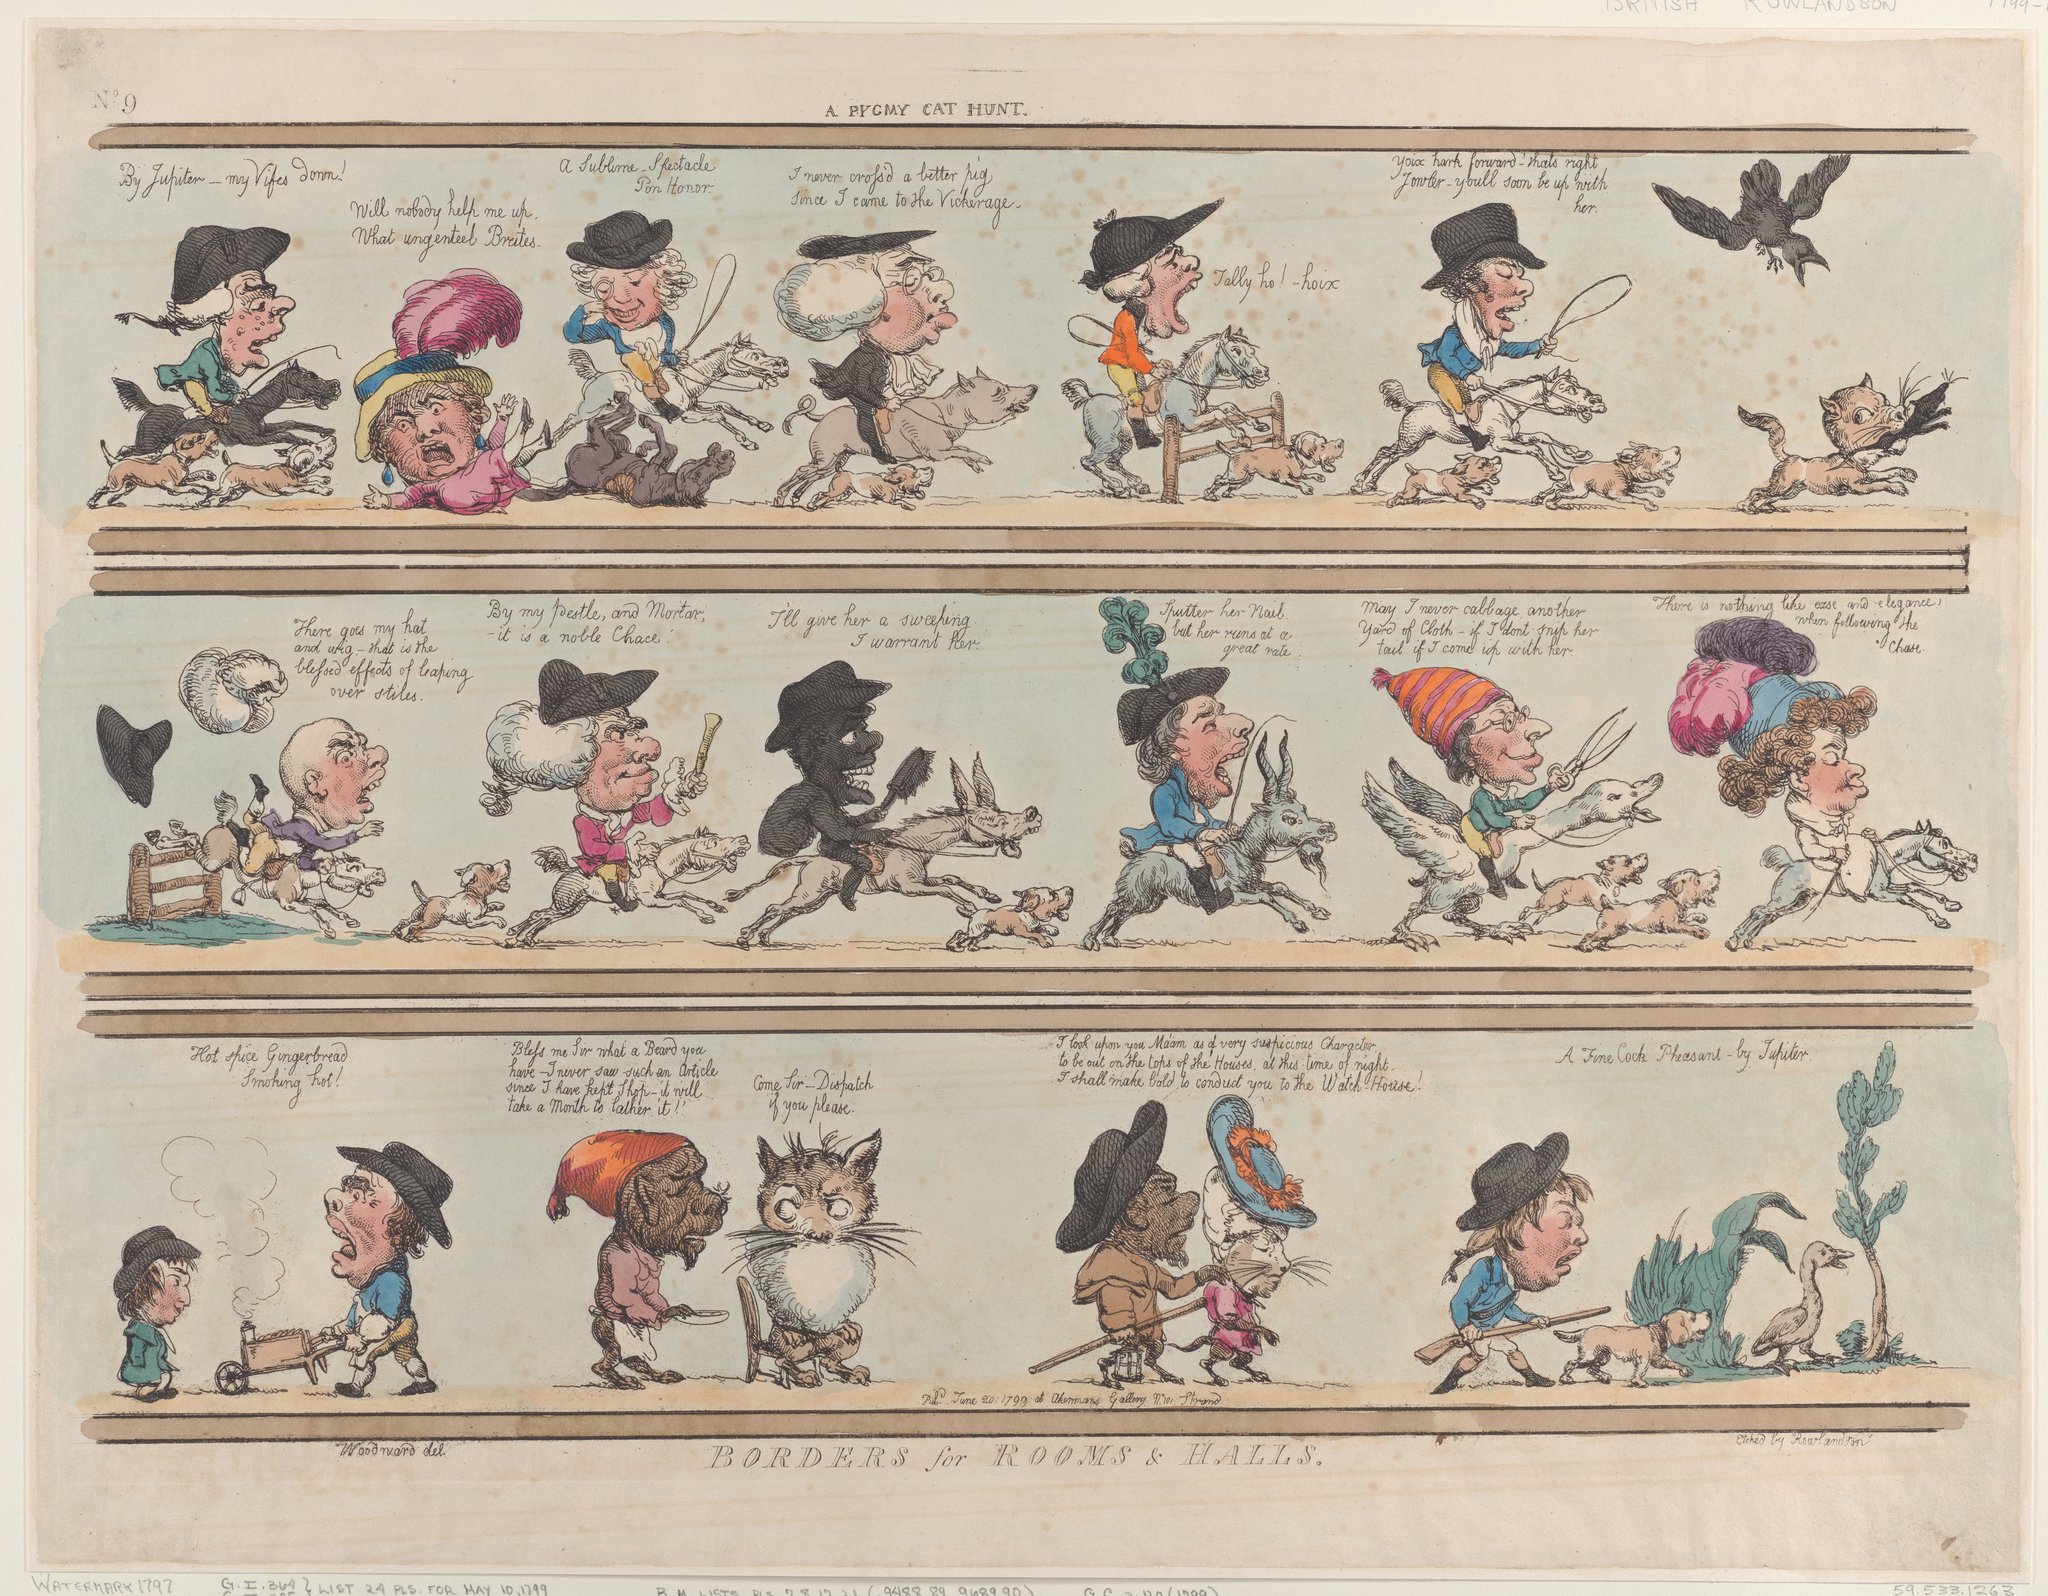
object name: print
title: A Pygmy Cat Hunt, Borders for Rooms & Halls, Plate 9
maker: thomas rowlandson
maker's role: artist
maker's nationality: british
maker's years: 1757-1827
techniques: etching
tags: birds,satire,men,hunting,dogs,horses